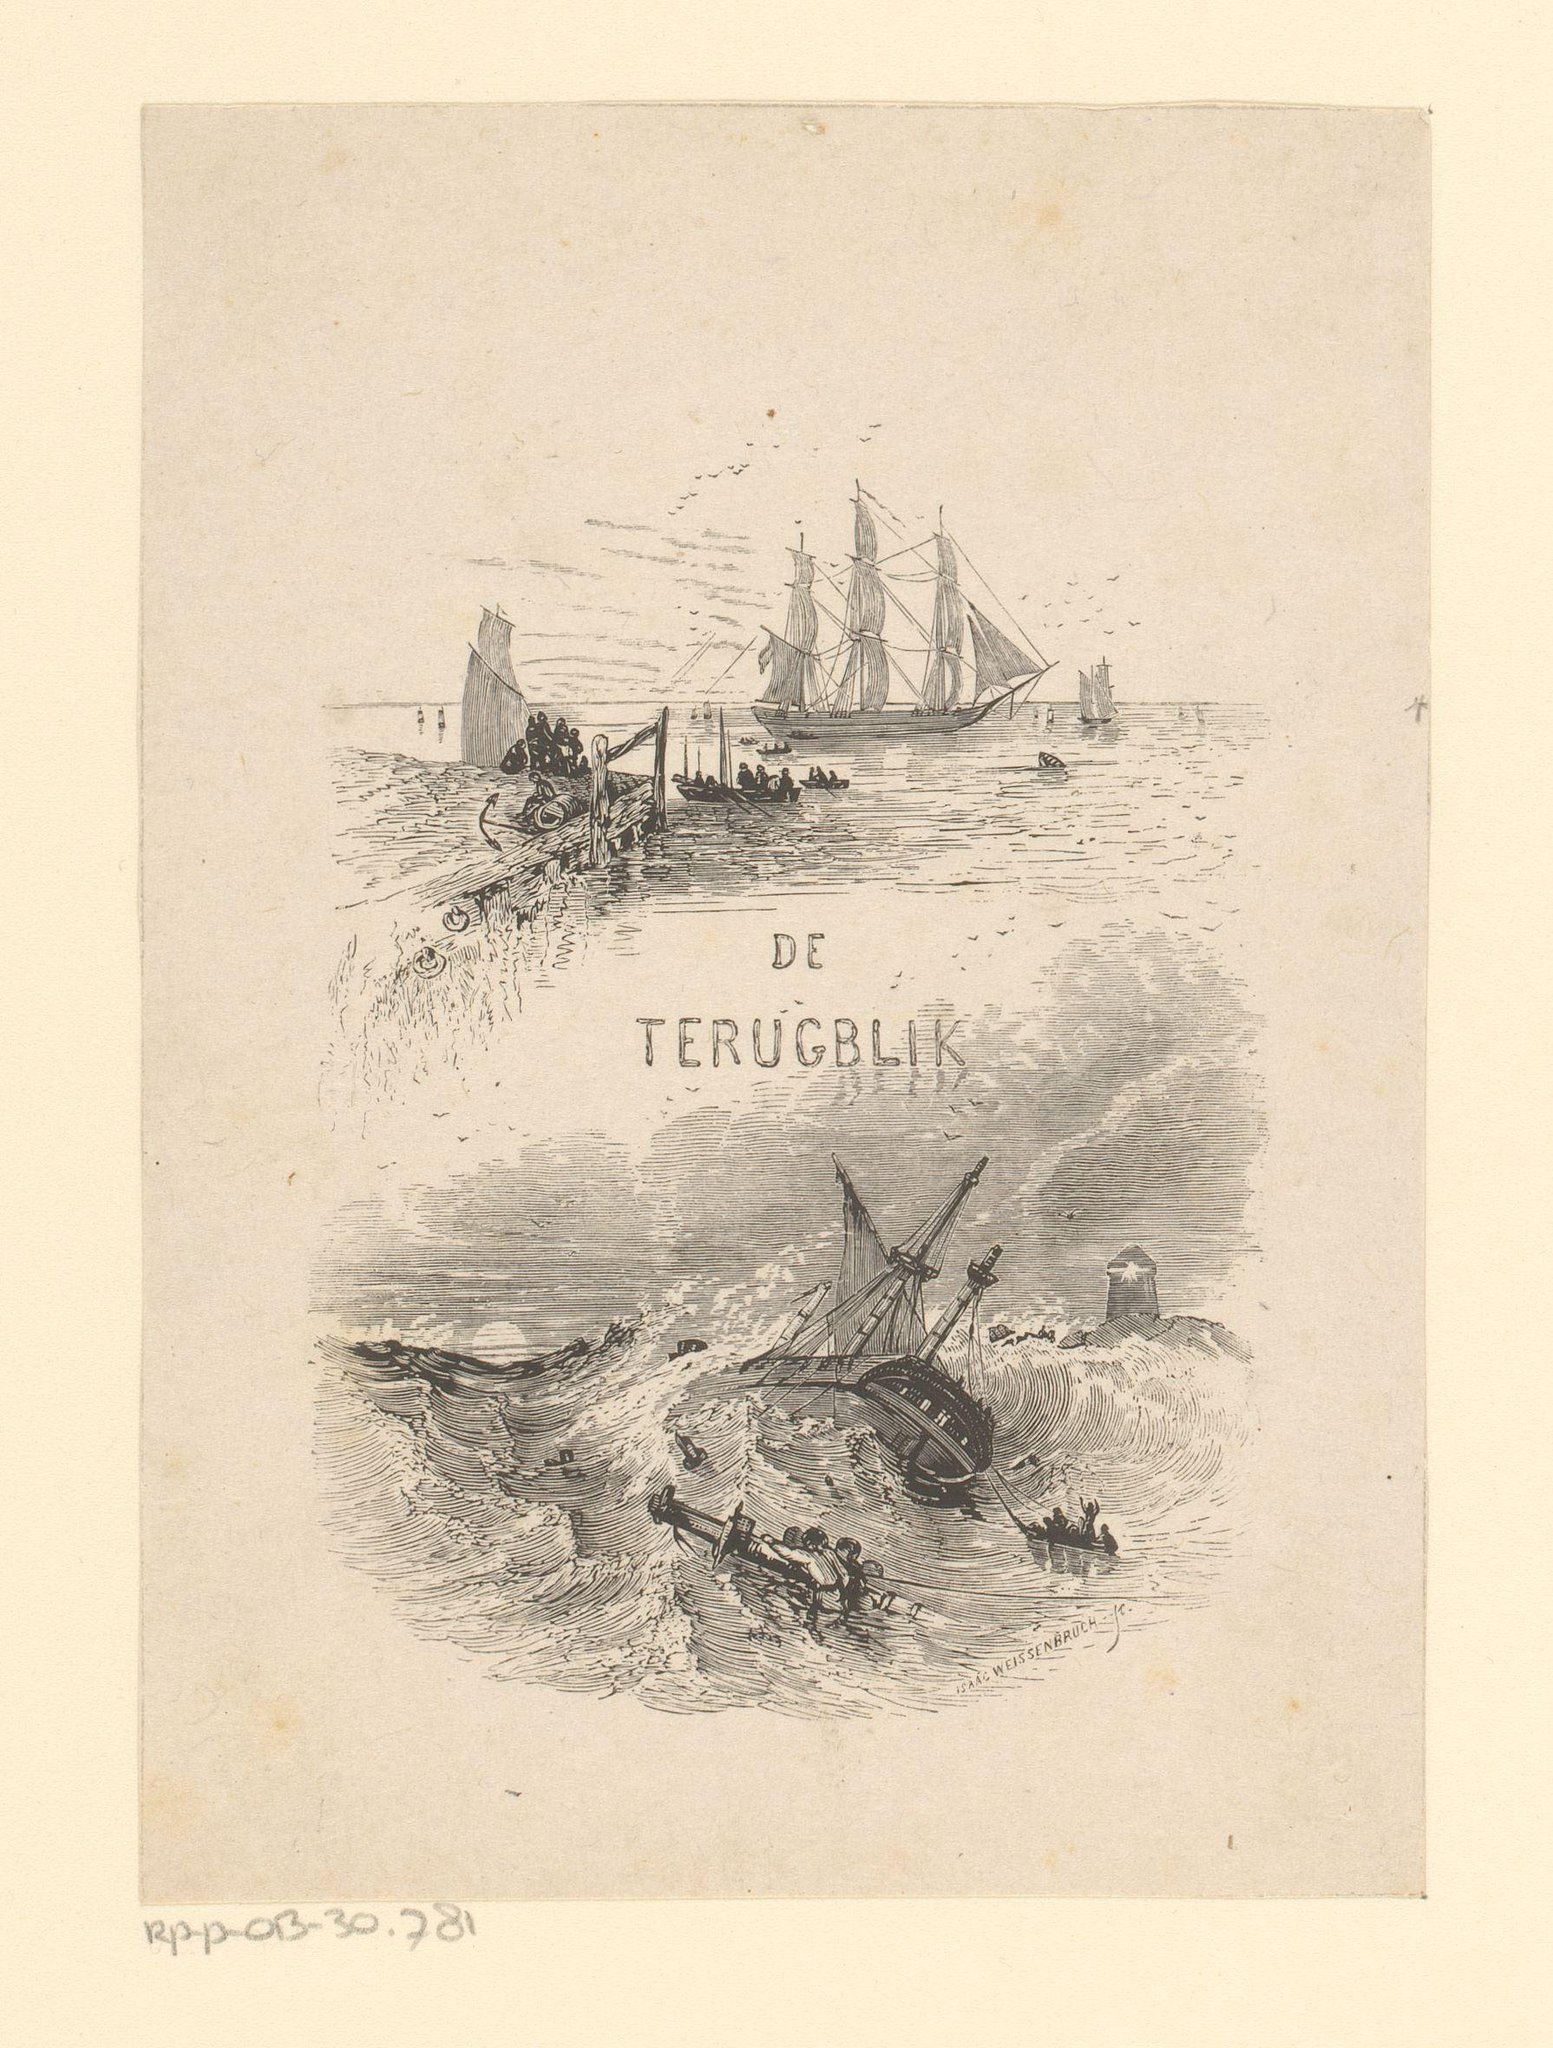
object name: titelblad, titelpagina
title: Fragment titelpagina voor: Richard Marks, De terugblik of Gods goedertierene leidingen, 1854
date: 1854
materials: paper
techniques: engraving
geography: amsterdam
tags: sailing-ship, sailing-boat, storm at sea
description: Boven een groep figuren in een boot varend van de kade naar een schip om daarmee te vertrekken. Onder een schip in de storm en figuren in de zee vasthoudend aan drijfhout.